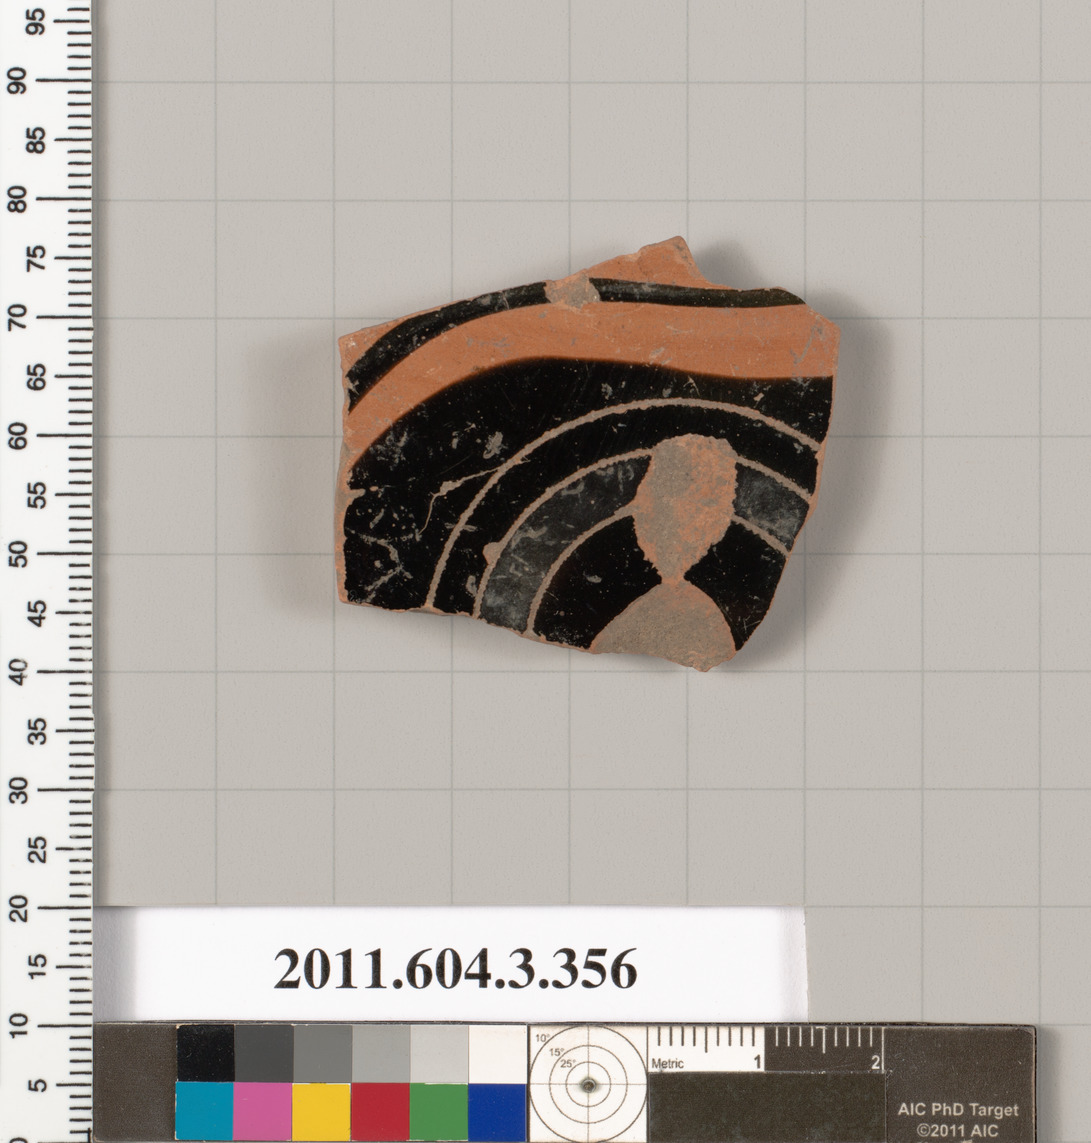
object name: neck amphora fragment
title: Terracotta fragment of a neck-amphora (jar)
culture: greek, attic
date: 525-501 BCE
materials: terracotta